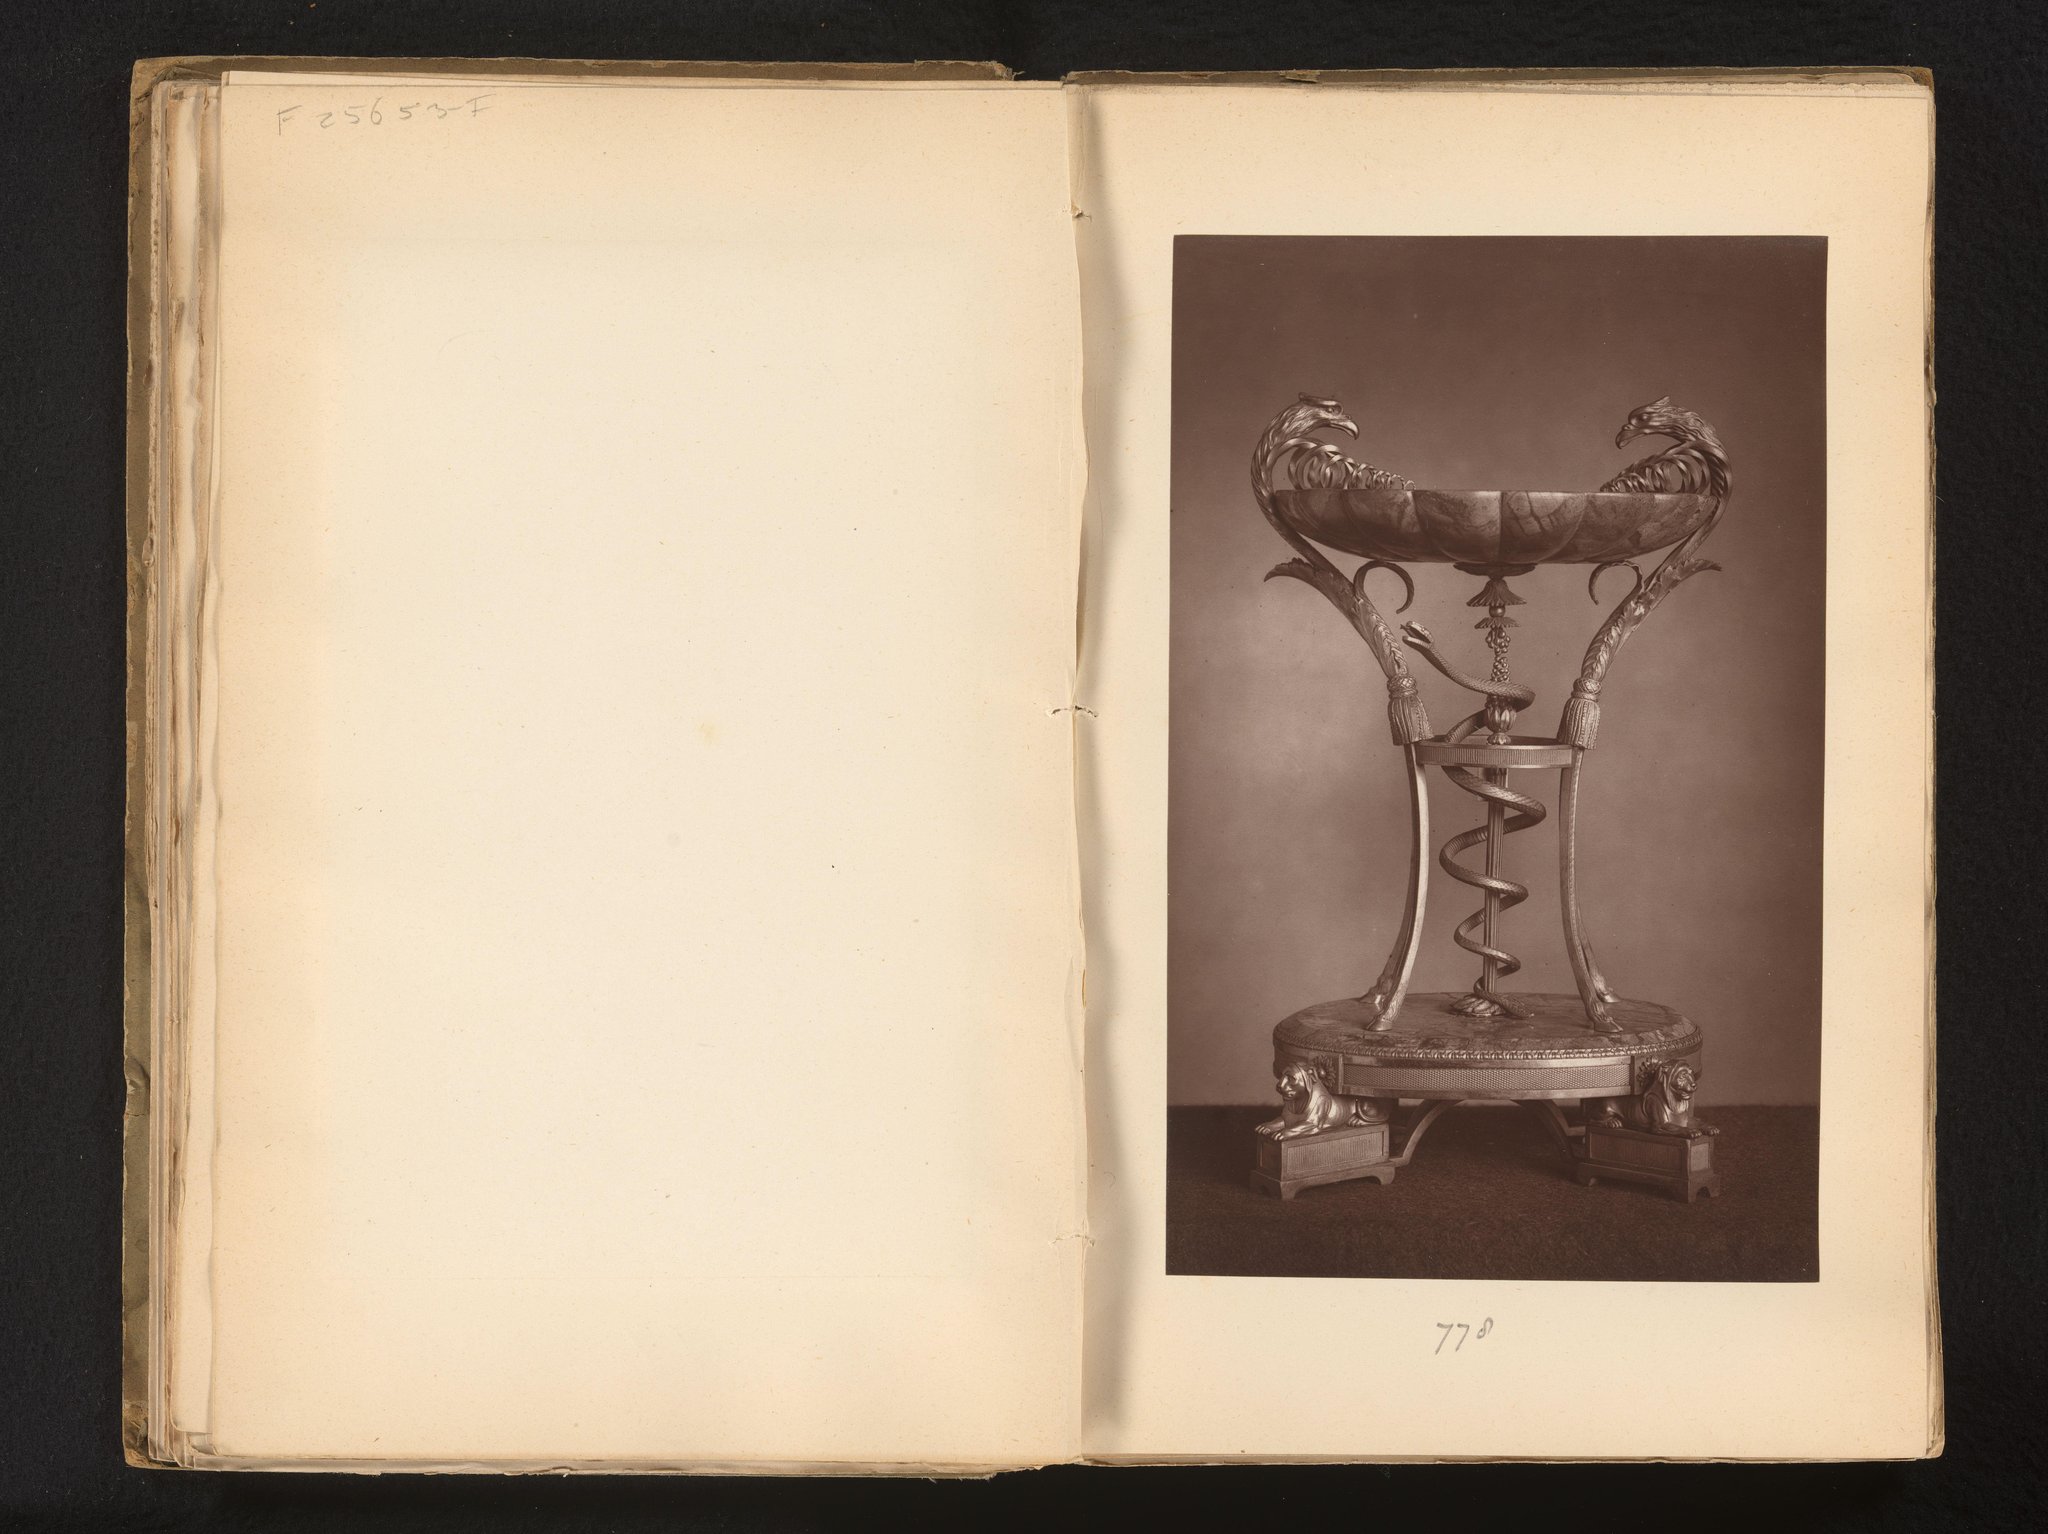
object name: page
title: Schaal van lapis lazuli op een voet, uit de collectie van Christopher Beckett Denison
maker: Anonymous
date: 1880-1885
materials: paper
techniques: woodburytype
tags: container of (semi-)precious stone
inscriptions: number: ‘778’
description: Prent op zevende ongenummerde pagina na pagina 74.